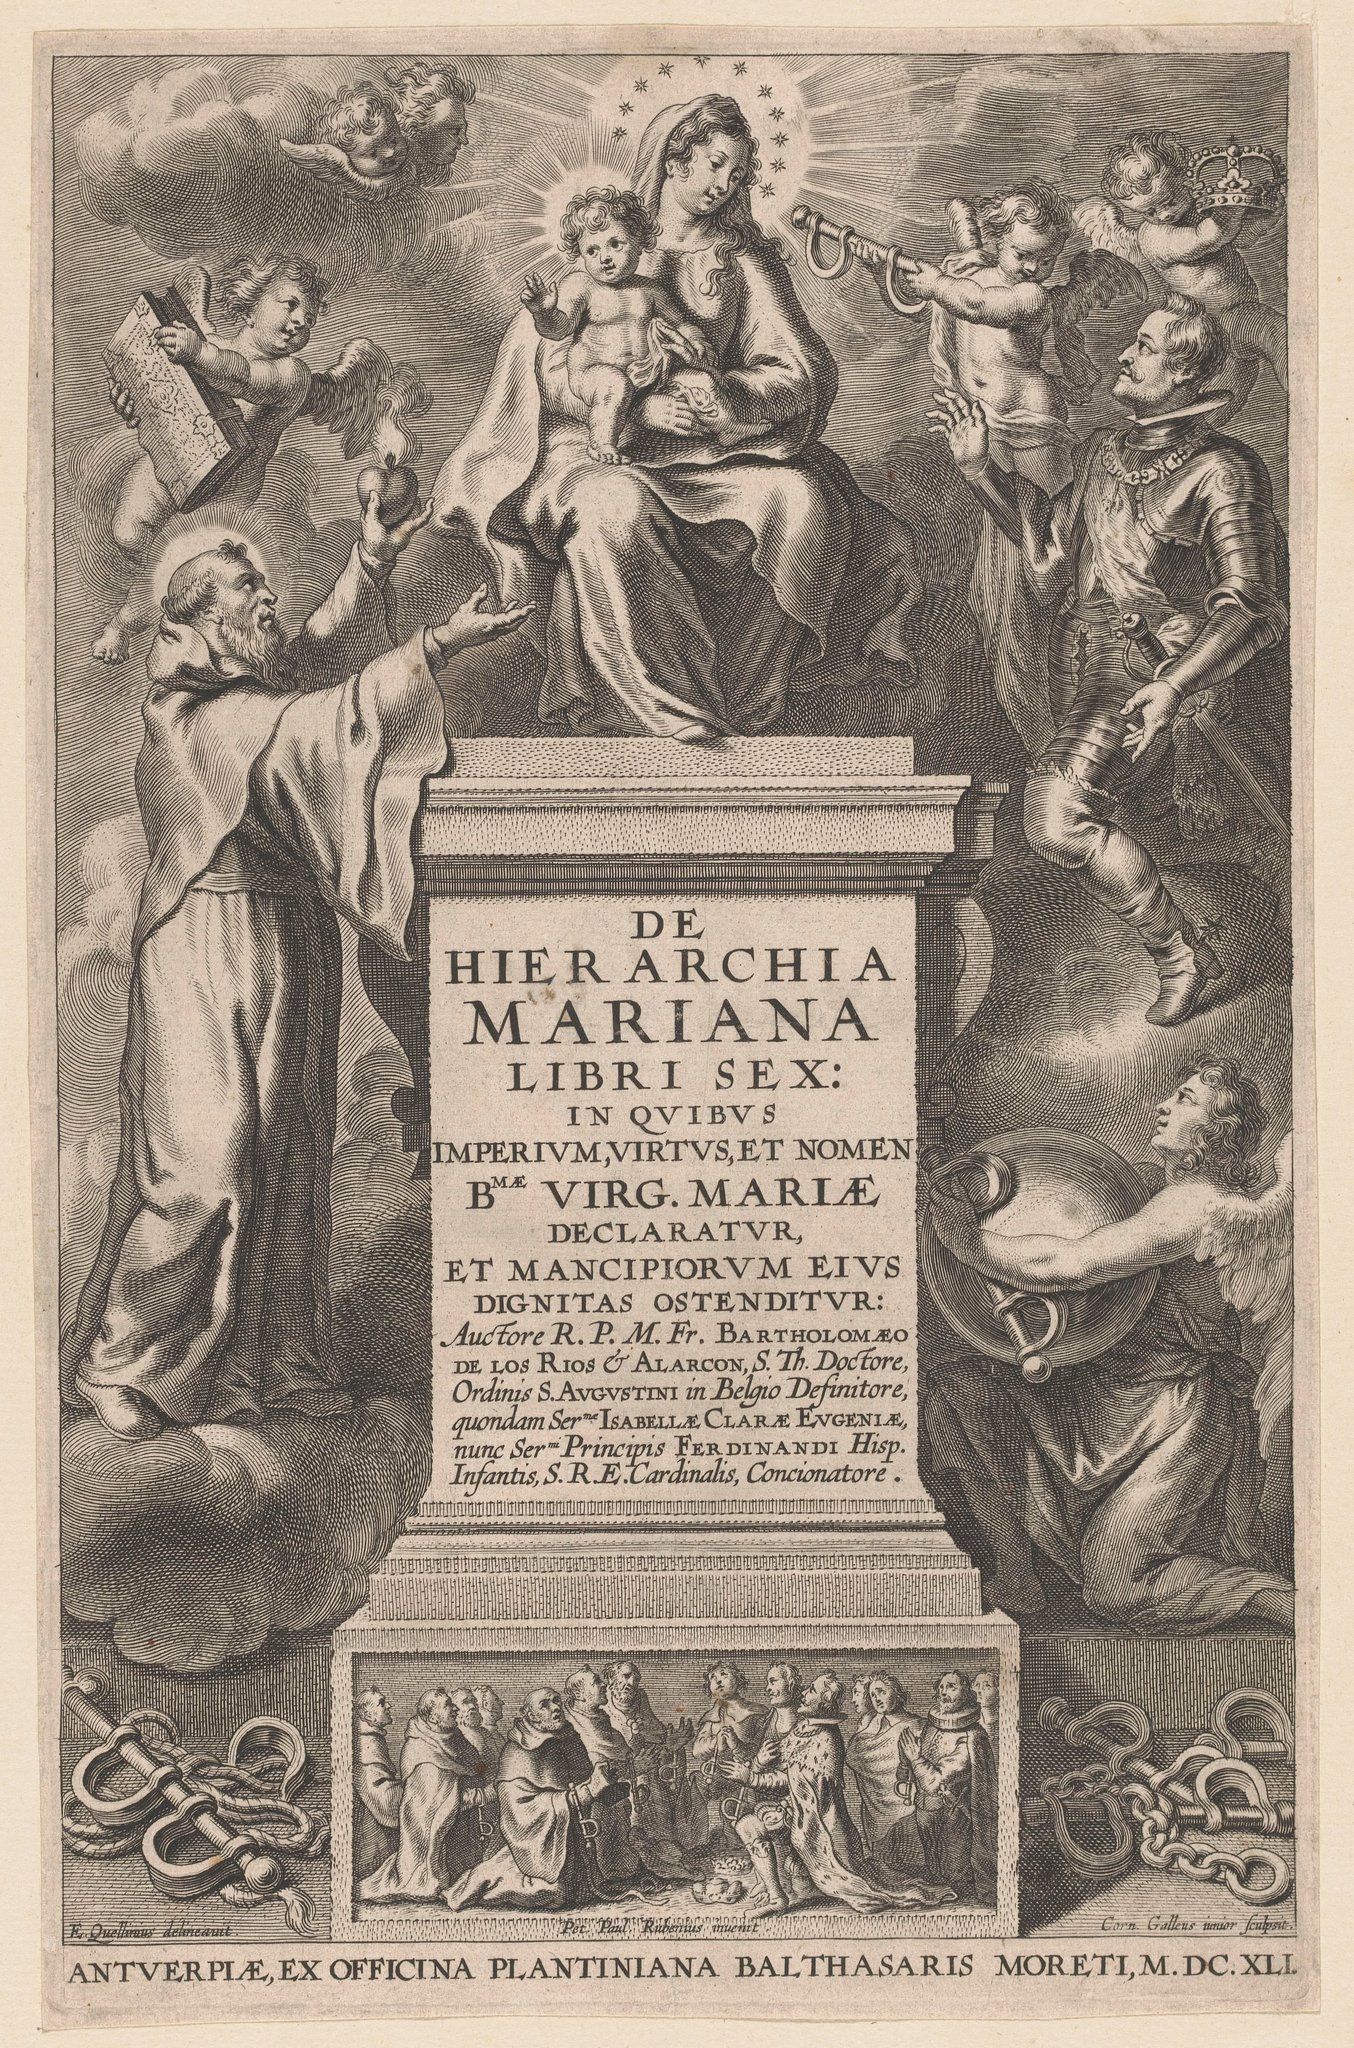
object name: print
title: Tronende Maria met Kind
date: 1640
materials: paper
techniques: engraving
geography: antwerp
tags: filips iv (koning van spanje), augustine, bishop of hippo; possible attributes: arrows piercing his breast, book, child with spoon, flaming heart, heart (pierced with arrows), pen, knighthood order, mary sitting or enthroned, the christ-child in front of her in her lap (or in front of her bosom), (person) in fetters, not imprisoned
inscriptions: collector's mark: Lugt 240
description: Maria met Kind troont op een piëdestal. Links Augustinus met het brandende hart in zijn hand. Rechts knielt koning Filips IV van Spanje. Op het piëdestal een groep kerkelijke en wereldlijke leiders in boeien geslagen, knielend voor Maria. De geboeide mannen verwijzen naar de Spaanse religieuze orde van de slaven van Maria (Congregación de los Esclavos del Dulcísimo Nombre de María).